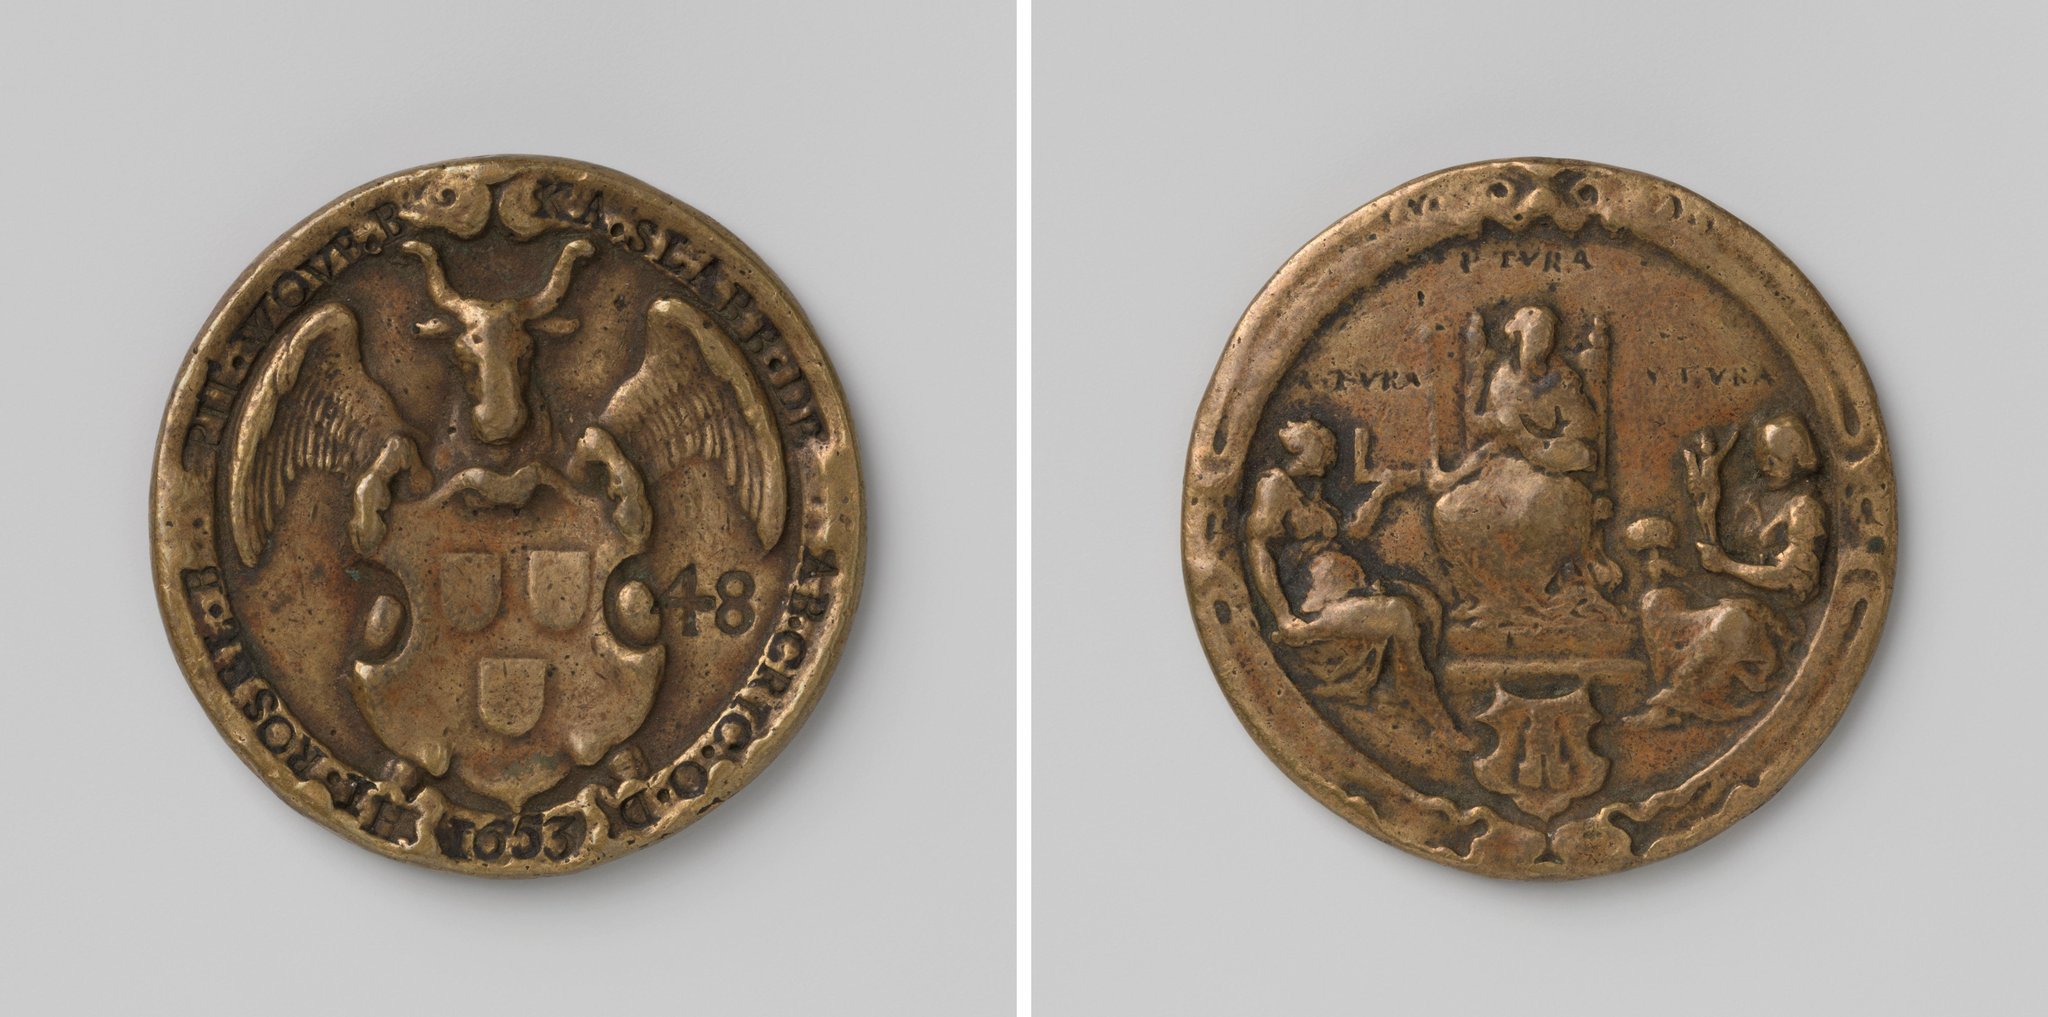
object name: medal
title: St. Lucasgilde van Middelburg, gildepenning met no. 48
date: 1653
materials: brass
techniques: casting, engraving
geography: middelburg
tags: middelburg